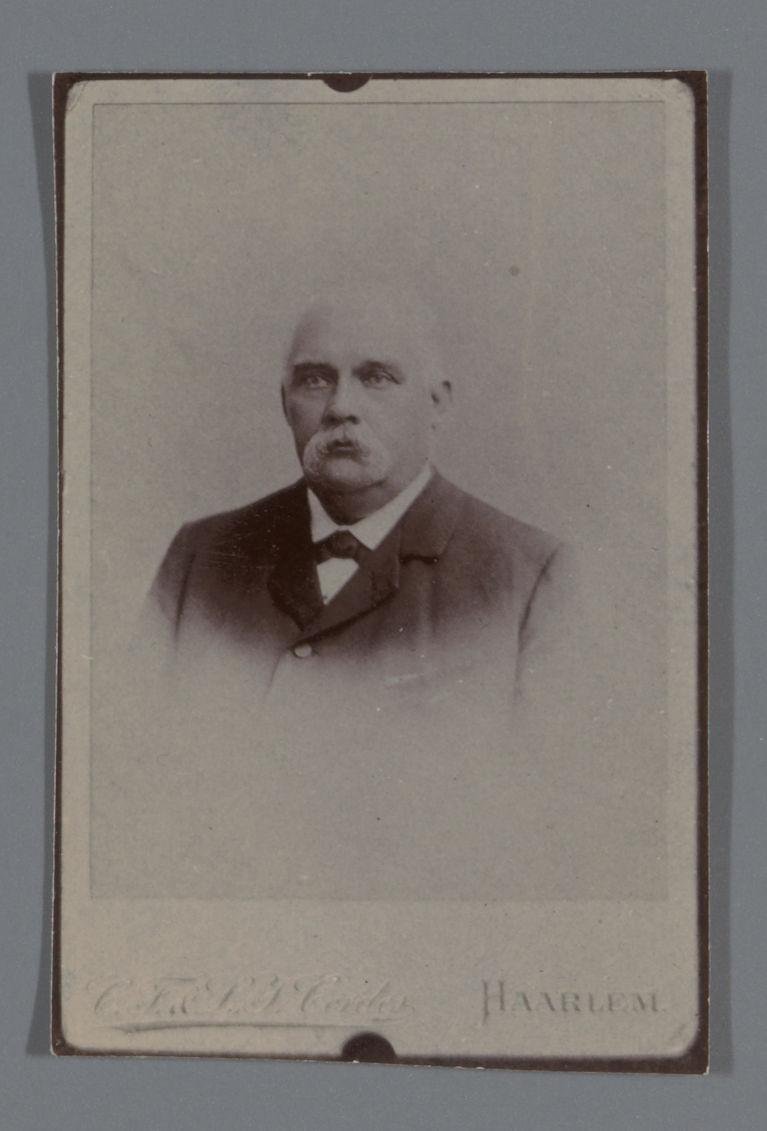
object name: photograph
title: Portret van een onbekende man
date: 1905-1915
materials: photographic support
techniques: gelatin silver print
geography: haarlem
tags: old man